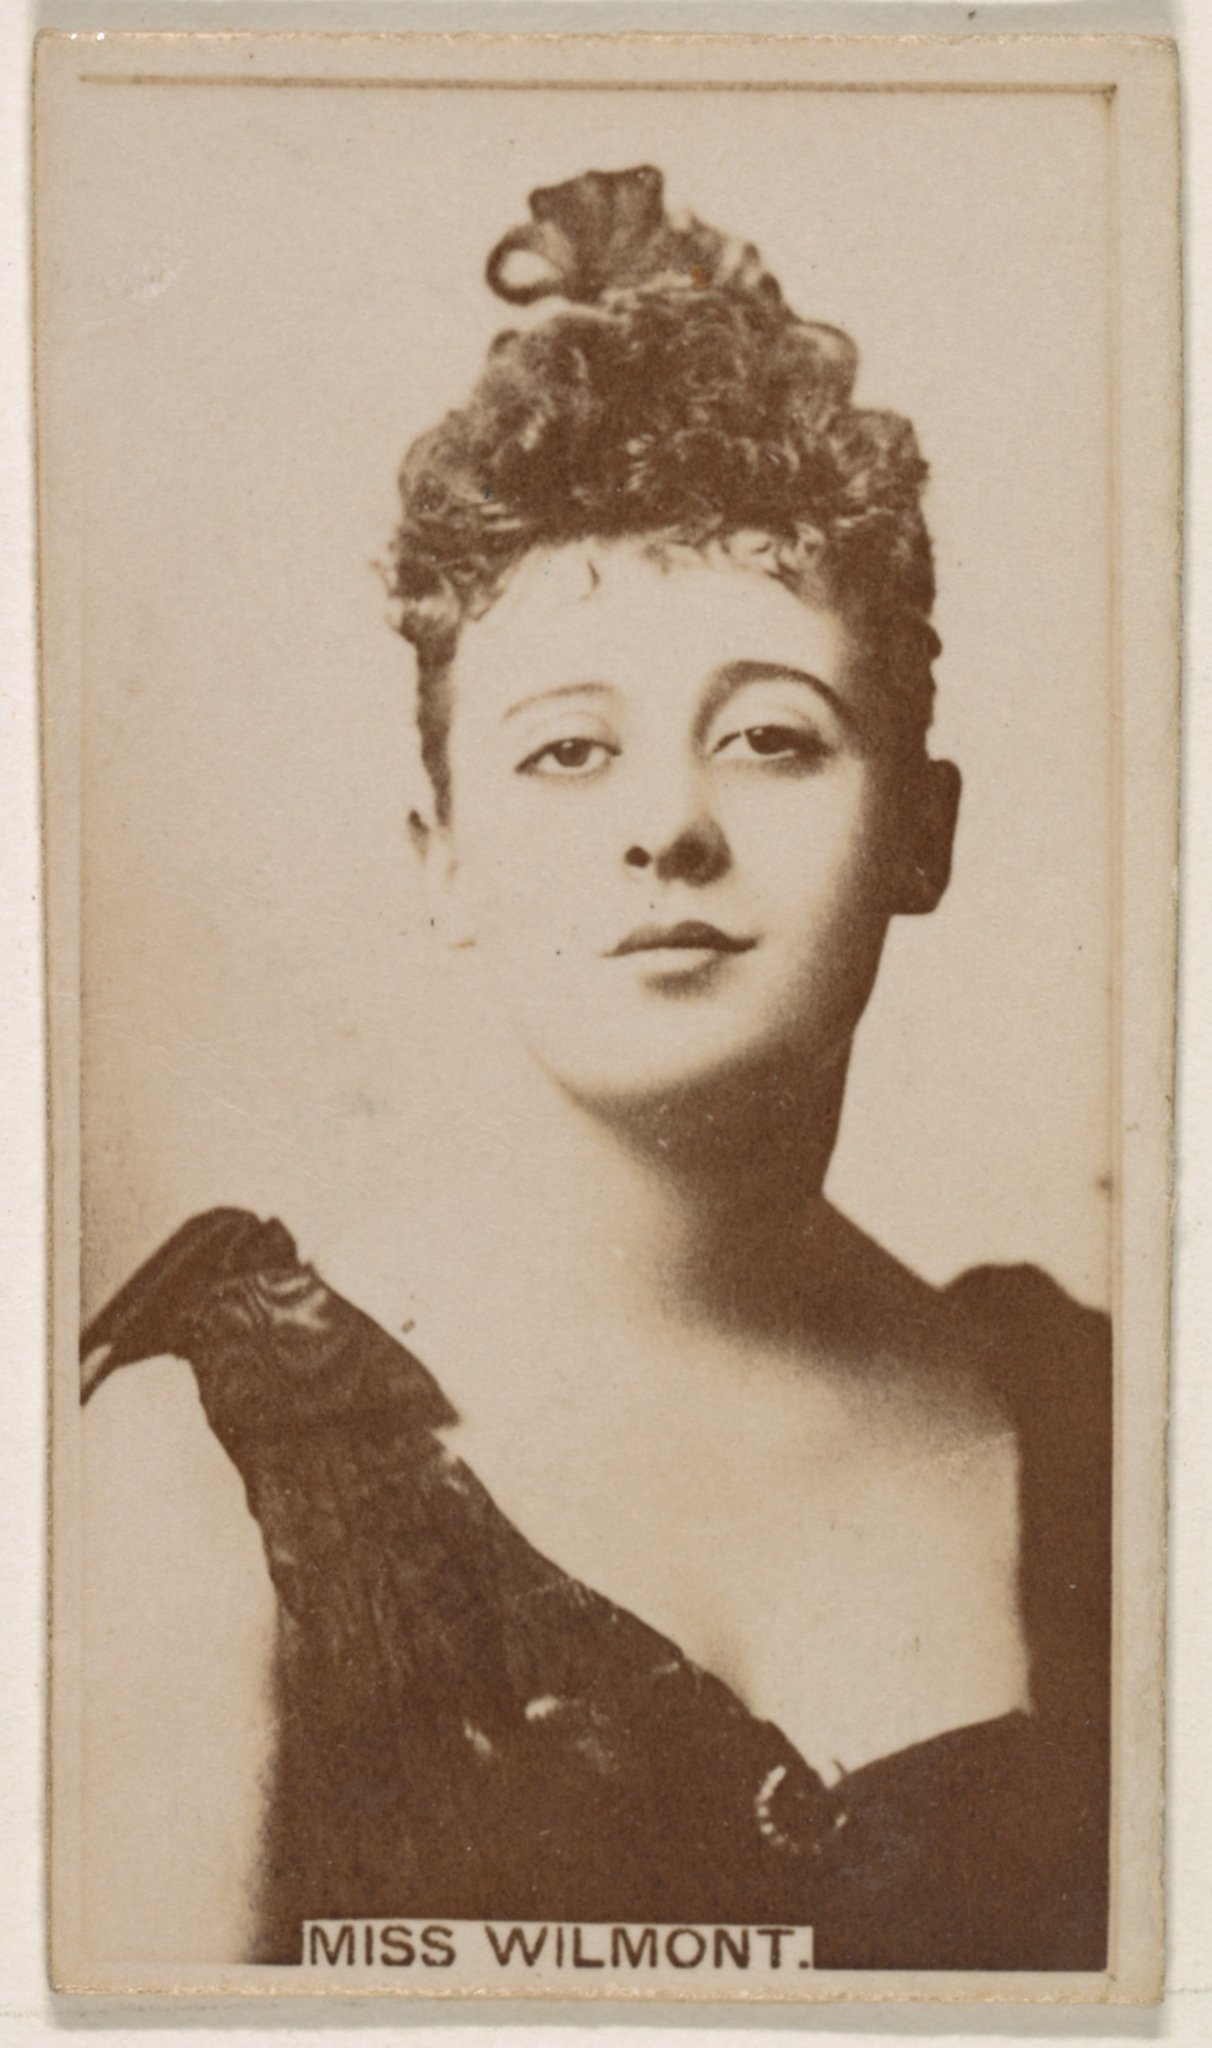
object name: photograph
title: Miss Wilmont, from the Actresses series (N245) issued by Kinney Brothers to promote Sweet Caporal Cigarettes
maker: kinney brothers tobacco company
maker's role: publisher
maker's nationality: american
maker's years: 1869-2011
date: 1890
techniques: albumen silver print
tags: portraits,women,actresses